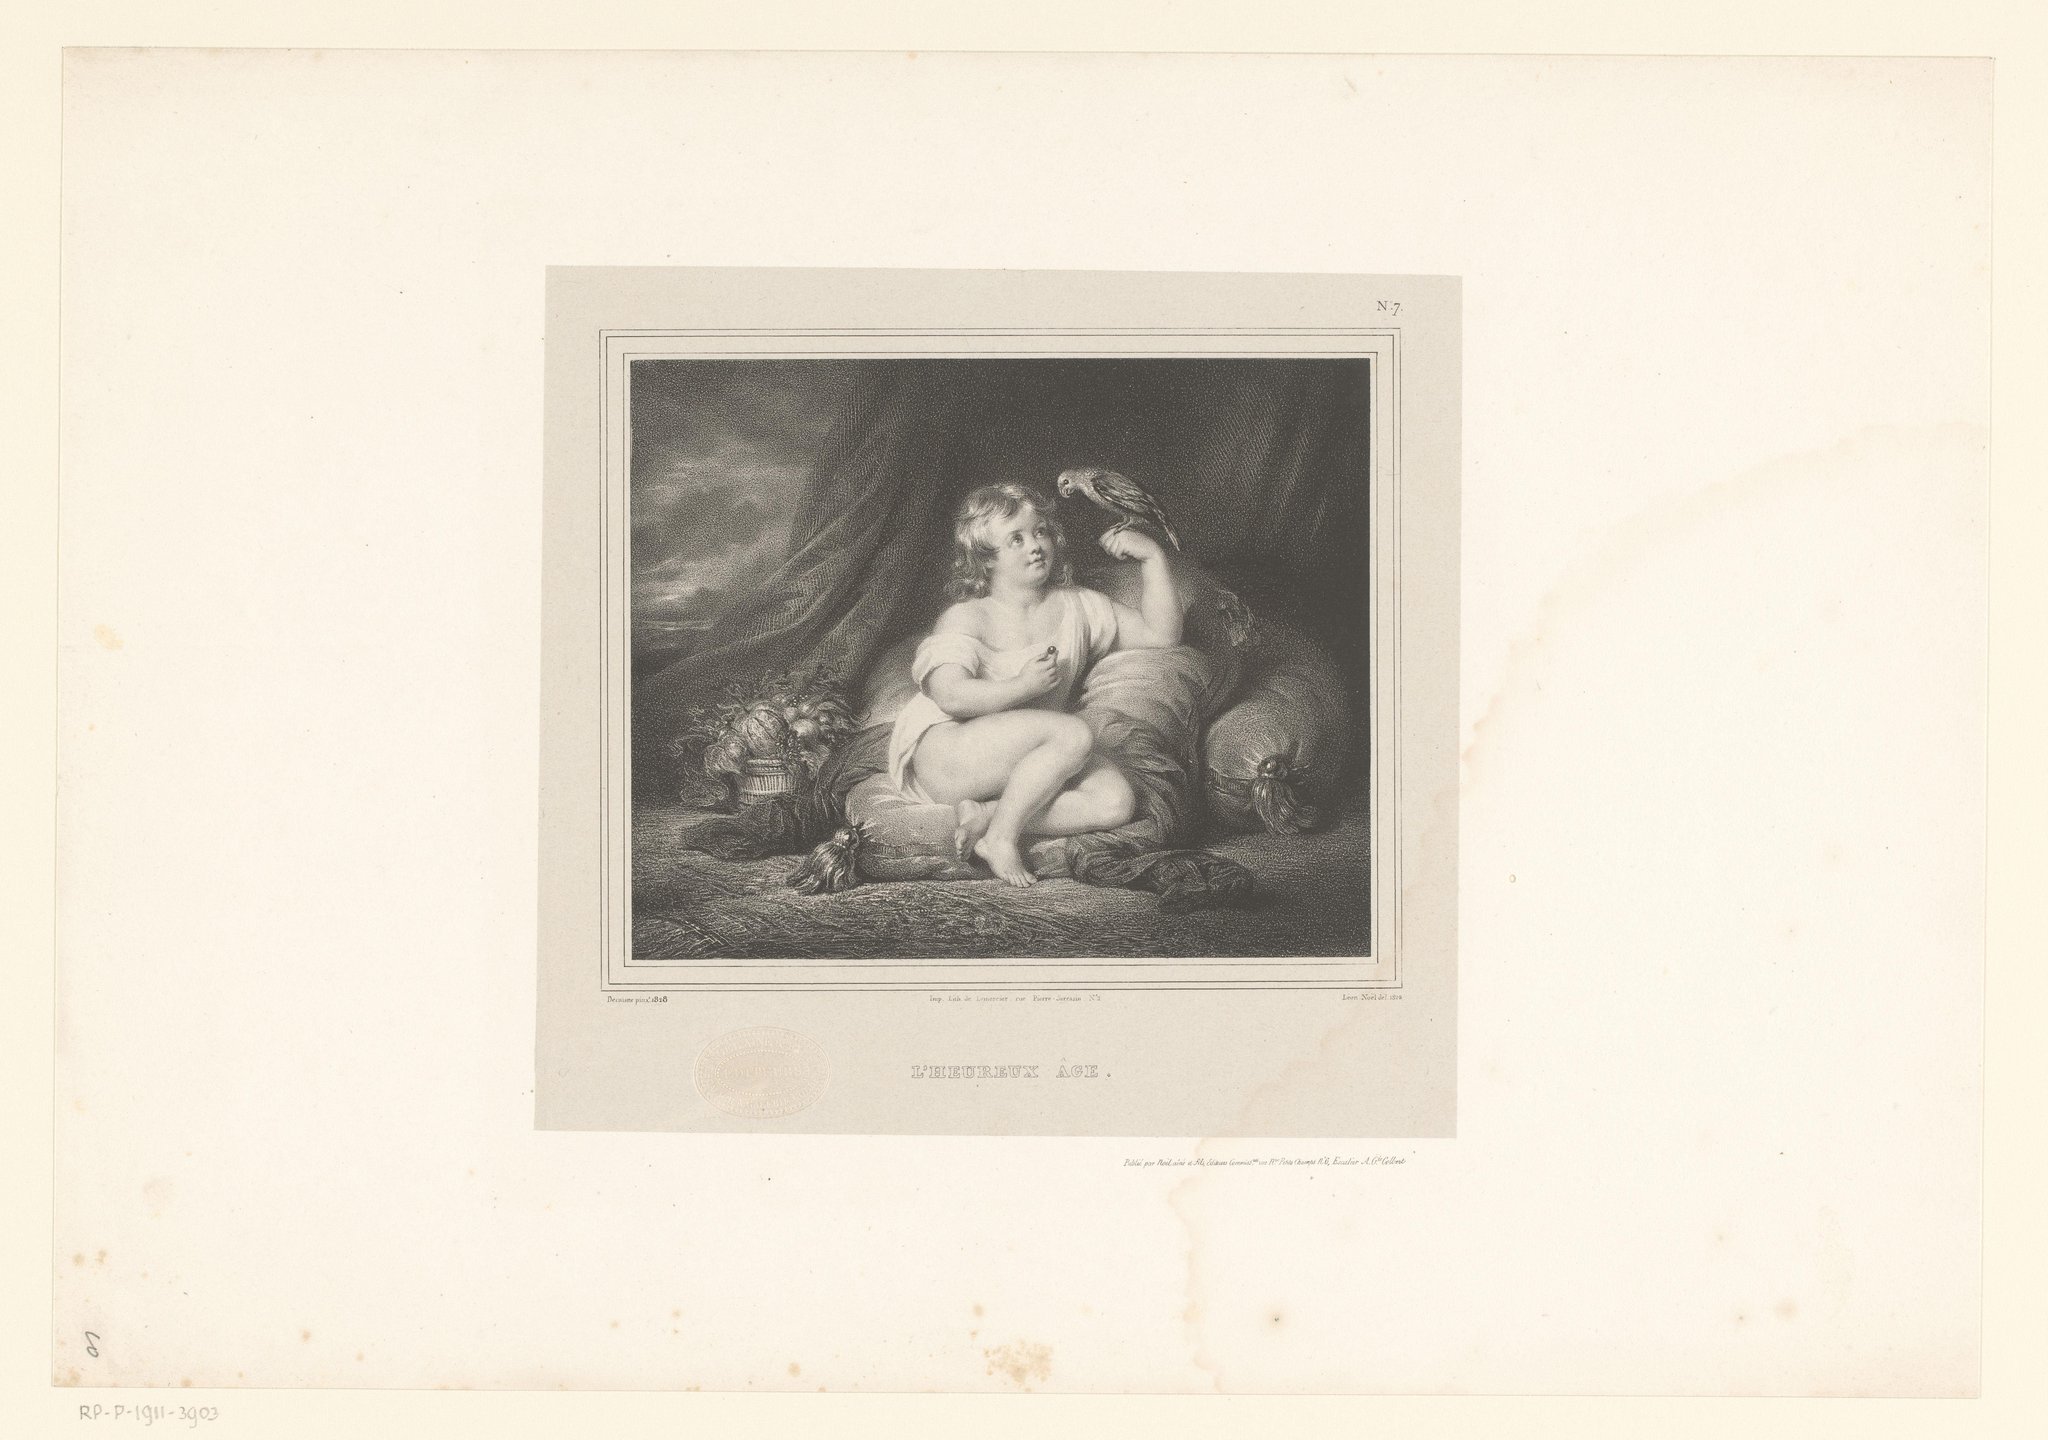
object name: print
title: Album met twaalf prenten naar Henri Decaisne door Léon Noël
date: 1828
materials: paper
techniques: lithograph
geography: paris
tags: other birds, child playing with animals, pillow, child (at home)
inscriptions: check stamp: Lugt 4944, collector's mark: Lugt 2228